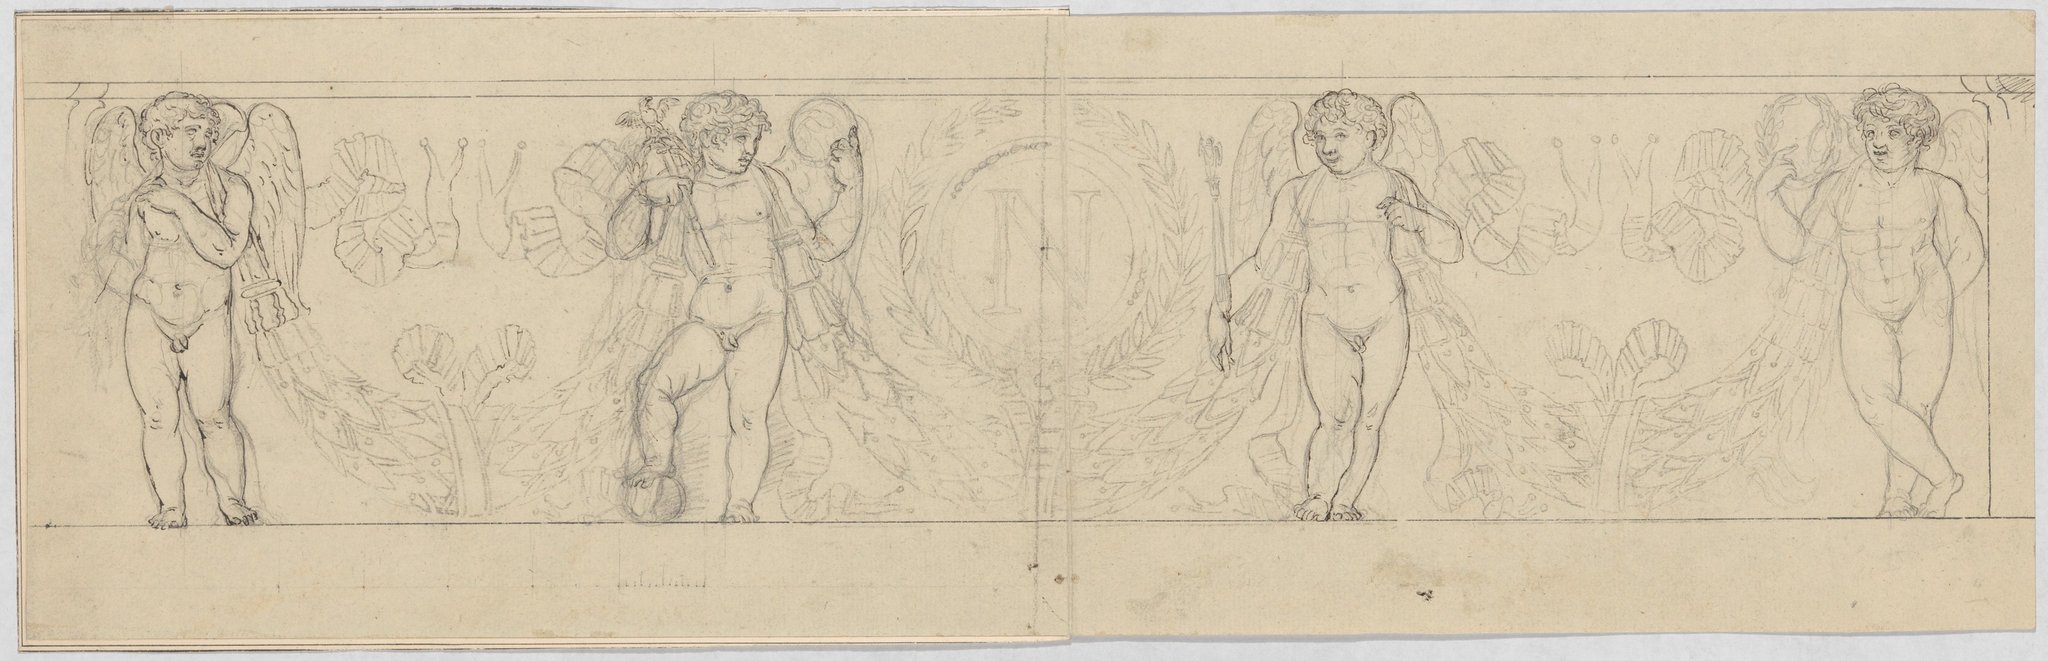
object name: drawing ornament architecture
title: Design for a Frieze with Putti Supporting a Garland, with the inital "N" inside a Wreath (related to the Arc du Carrousel)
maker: anonymous, french, 19th century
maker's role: artist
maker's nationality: french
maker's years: 1800-1900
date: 1806-1808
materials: graphite, ink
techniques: pen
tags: putti